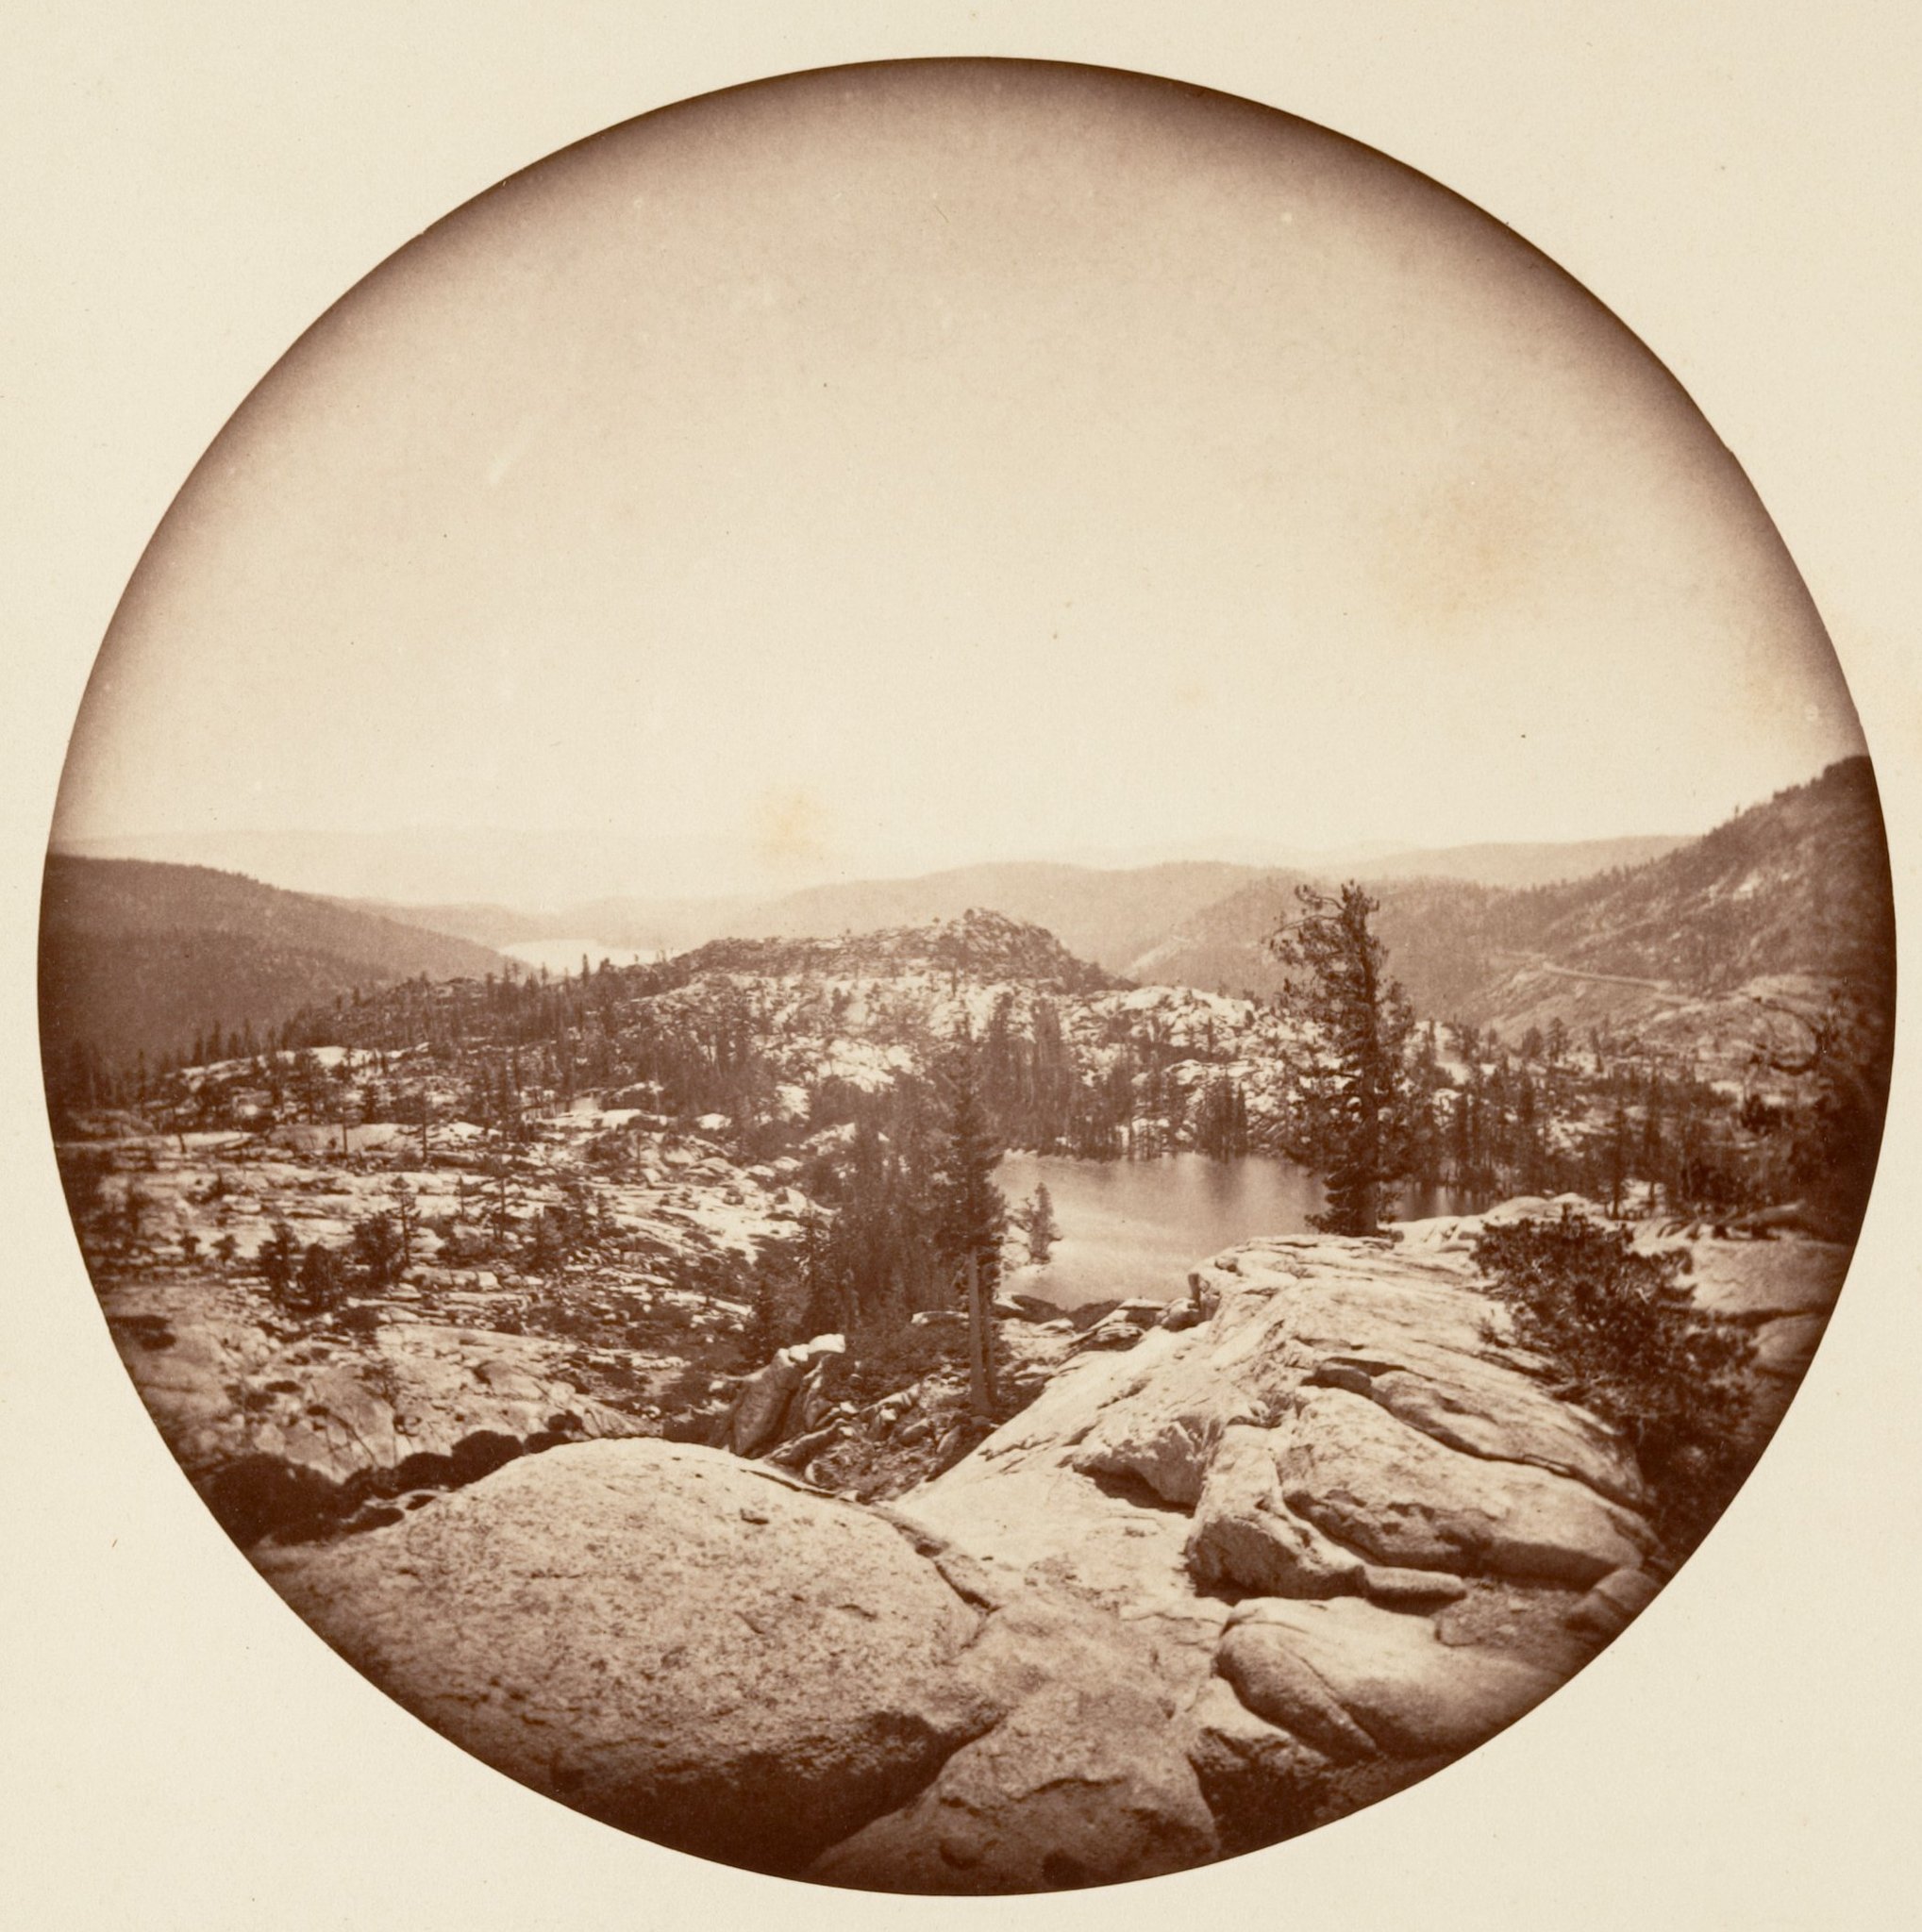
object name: photograph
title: [Yosemite National Park, California]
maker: carleton e. watkins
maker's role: artist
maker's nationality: american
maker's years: 1829-1916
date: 1878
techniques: albumen silver print, glass negative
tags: mountains,landscapes